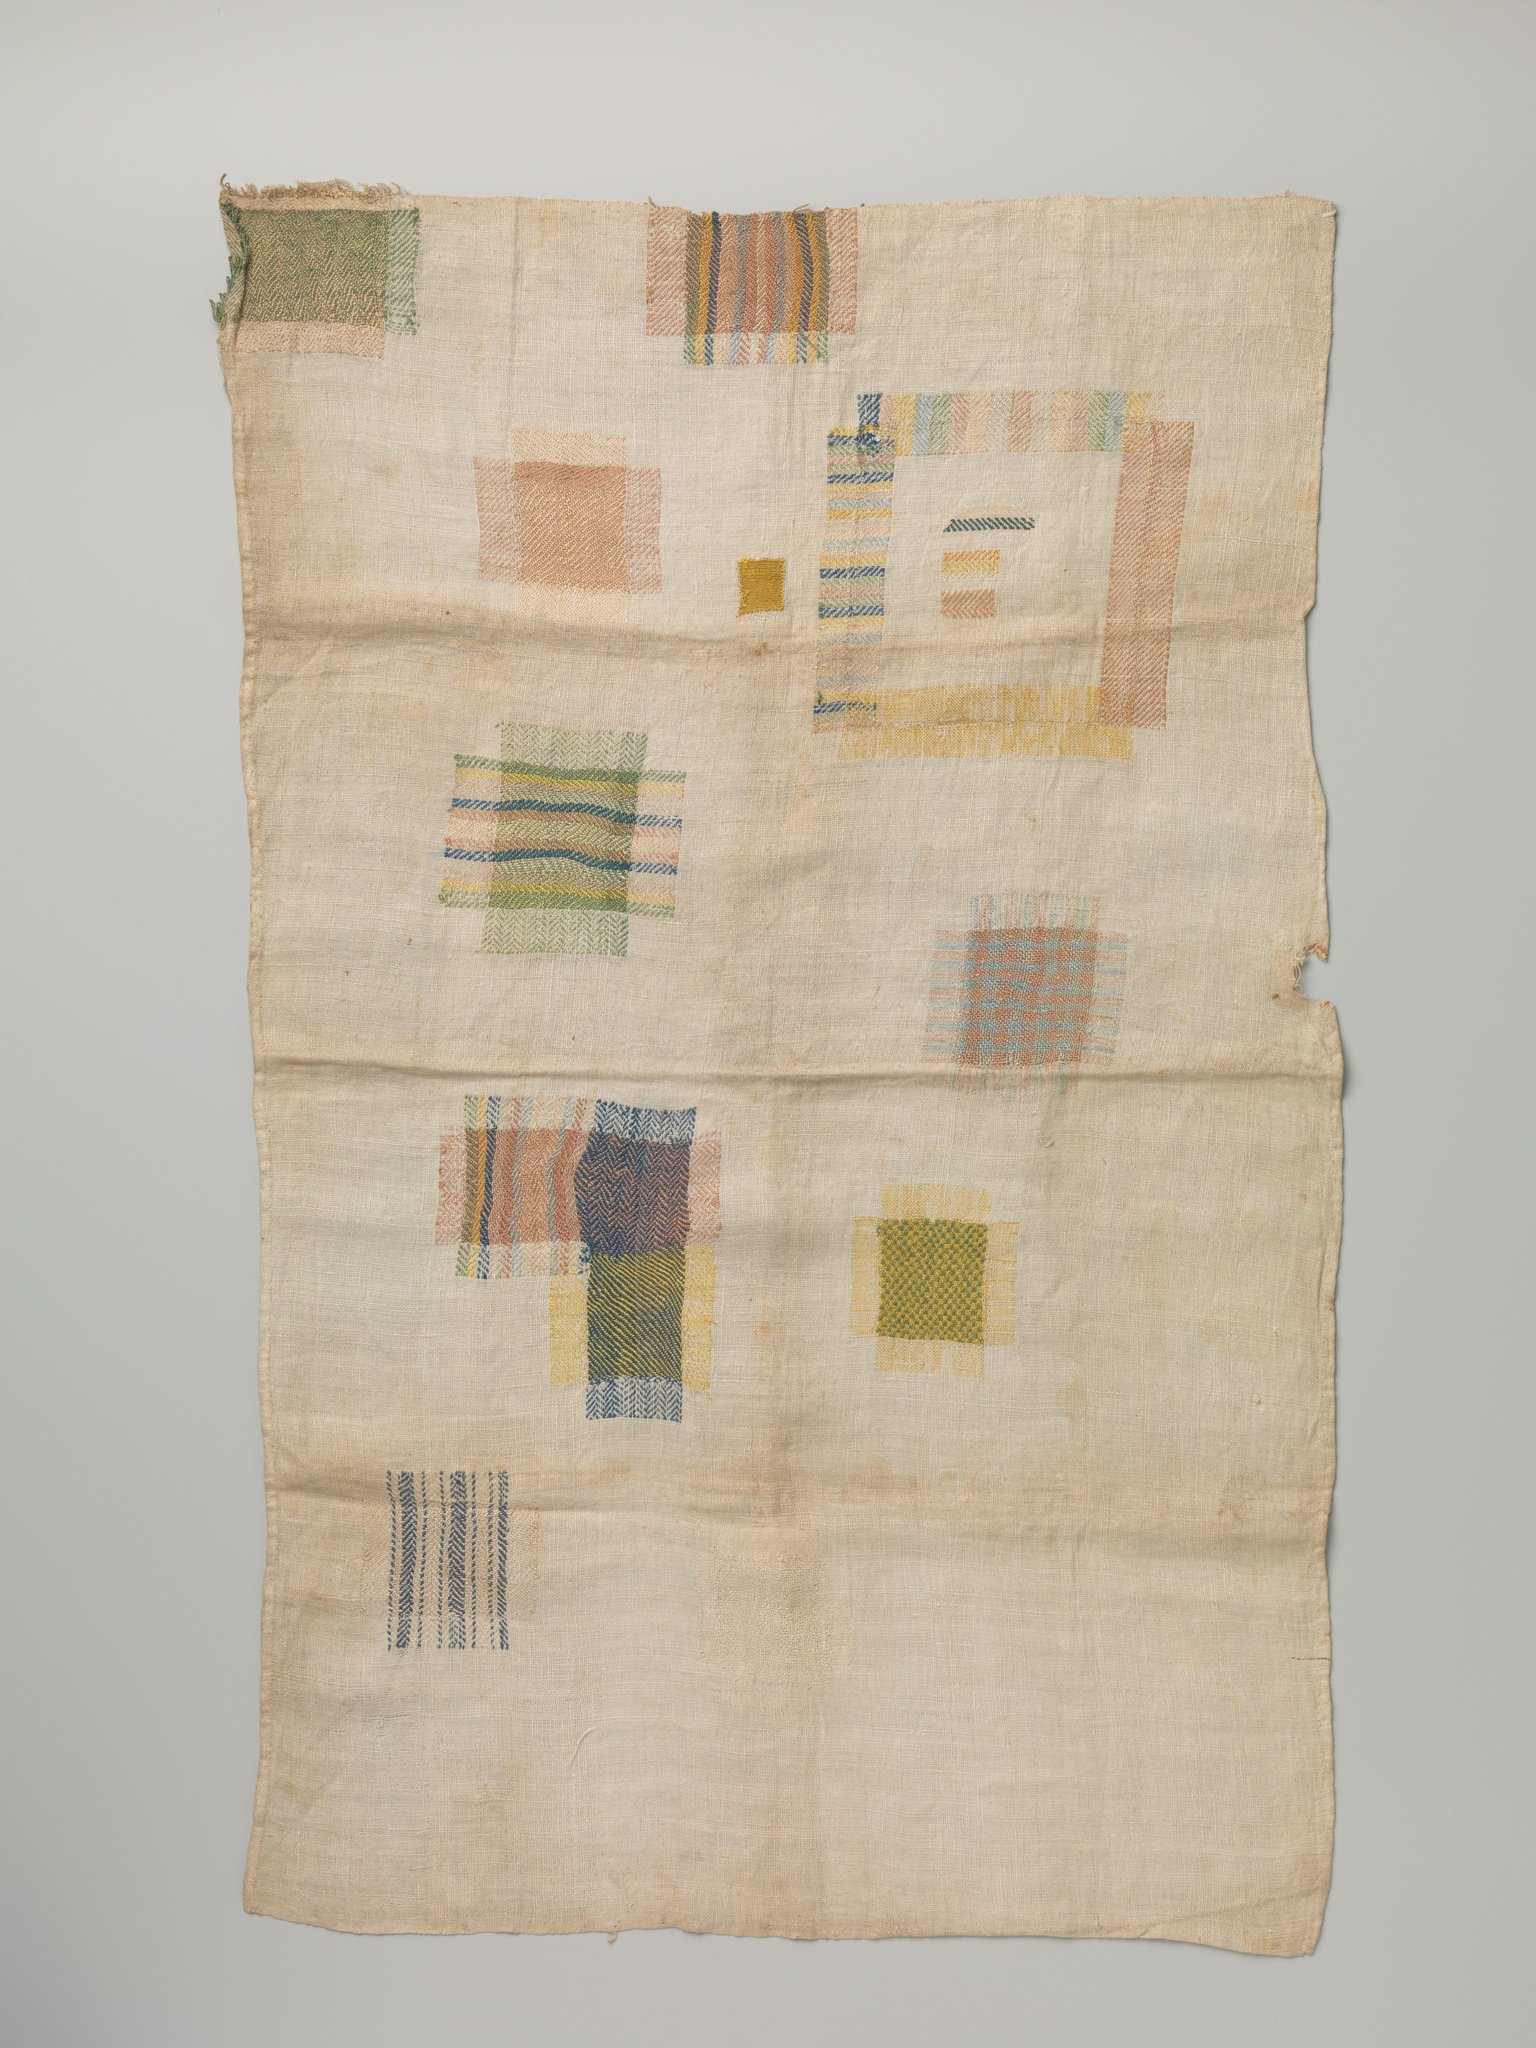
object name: stoplap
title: Stoplap van veelkleurige zijde en linnen op linnen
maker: Anonymous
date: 1760-1780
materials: linen, silk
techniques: embroidered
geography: netherlands